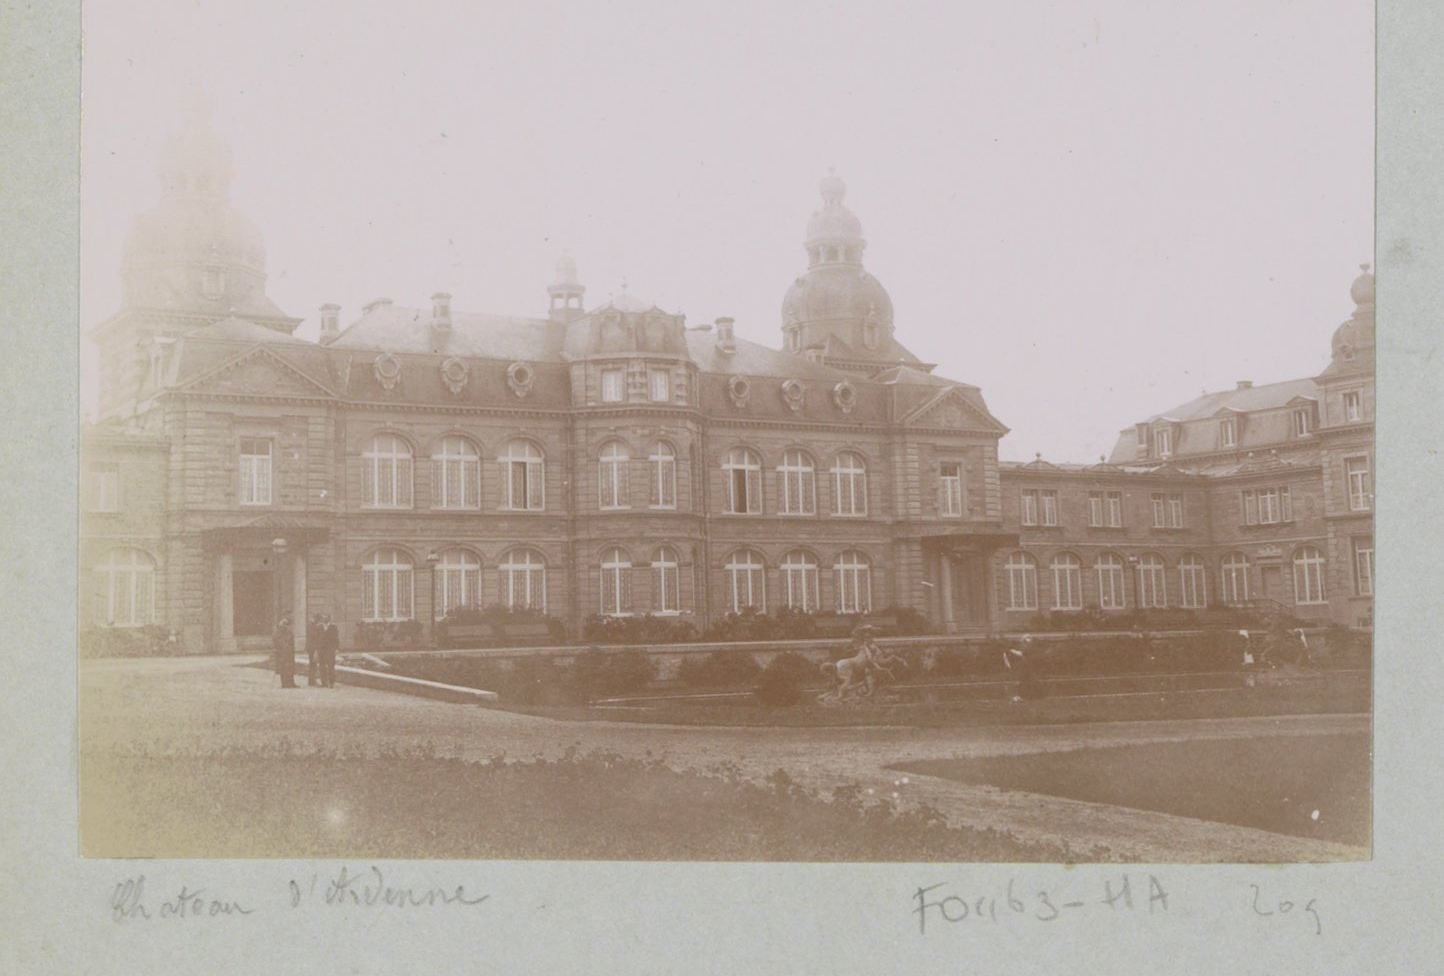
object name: photograph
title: Gezicht op de binnenplaats van Chateau Royal d'Ardenne te Houyet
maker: delizy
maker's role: manufacturer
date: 1898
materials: paper, photographic support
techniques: gelatin silver print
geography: houyet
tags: castle, courtyard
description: Onderdeel van Fotoalbum van een Franse amateurfotograaf met opnames van uitstapjes in Frankrijk, Spanje, België, Luxemburg en Nederland, de eerste automobielen en autoraces.